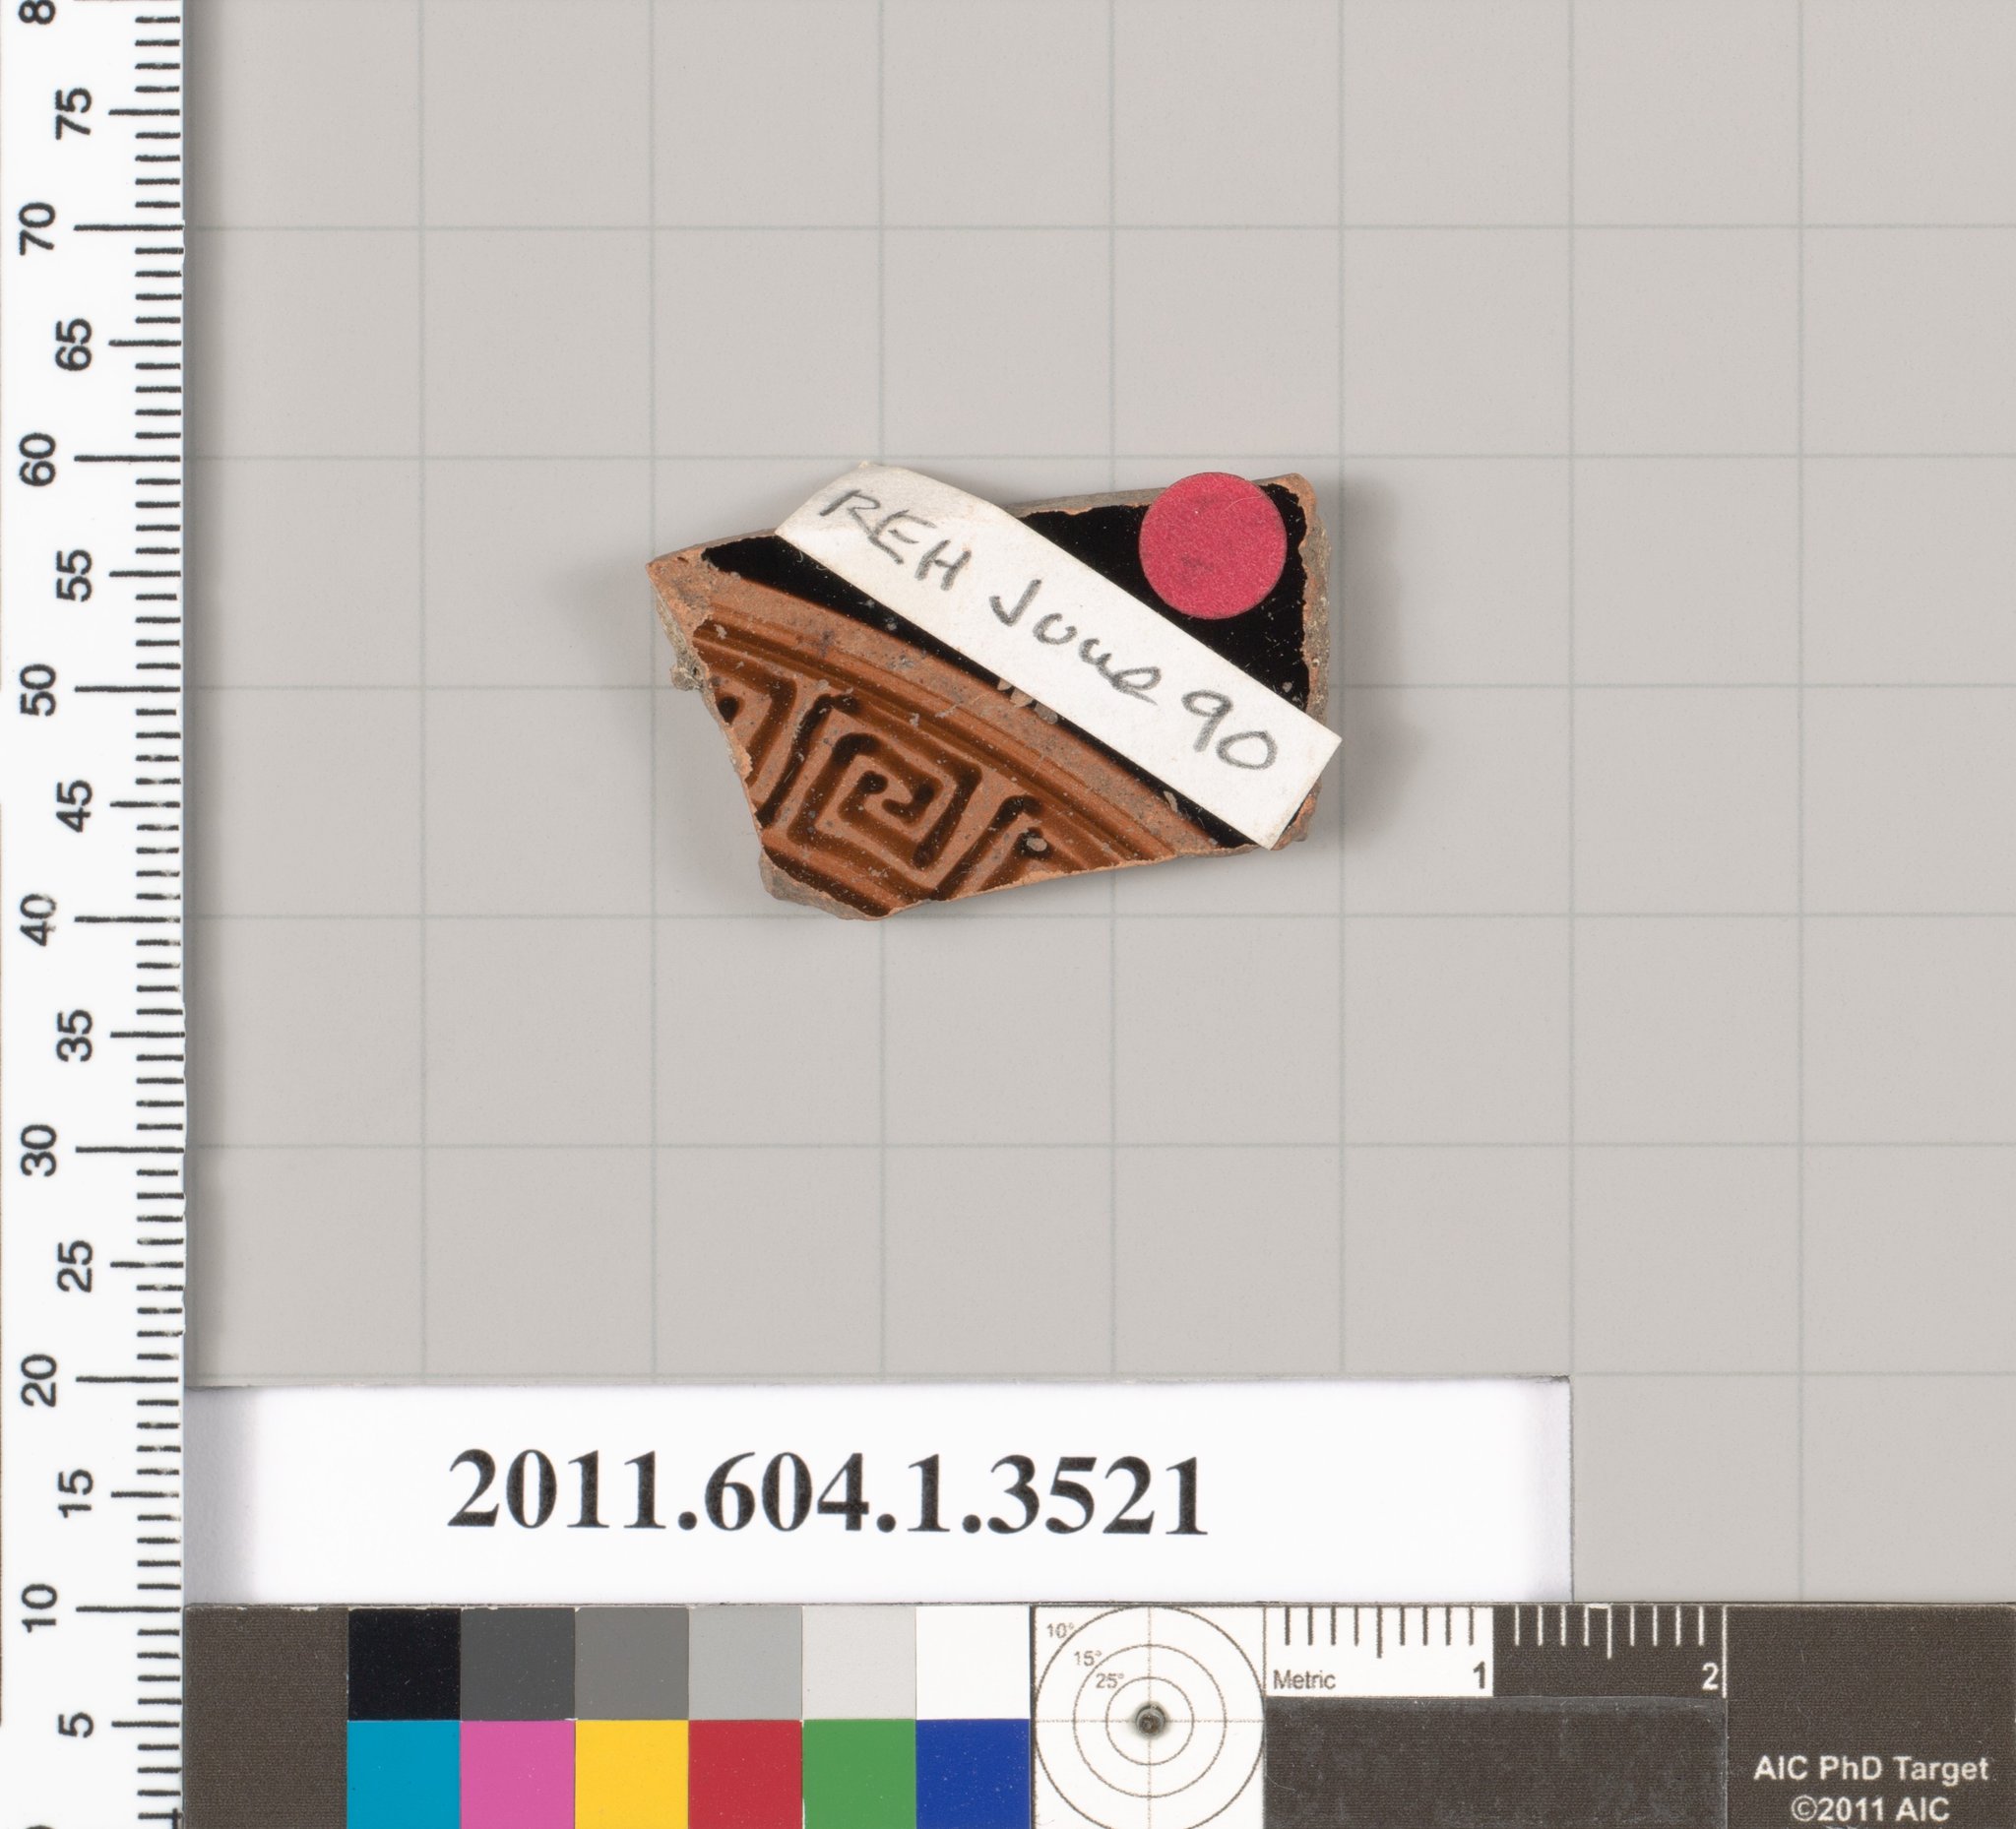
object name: kylix fragment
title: Terracotta fragment of a kylix (drinking cup)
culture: greek, attic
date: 490-480 BCE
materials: terracotta